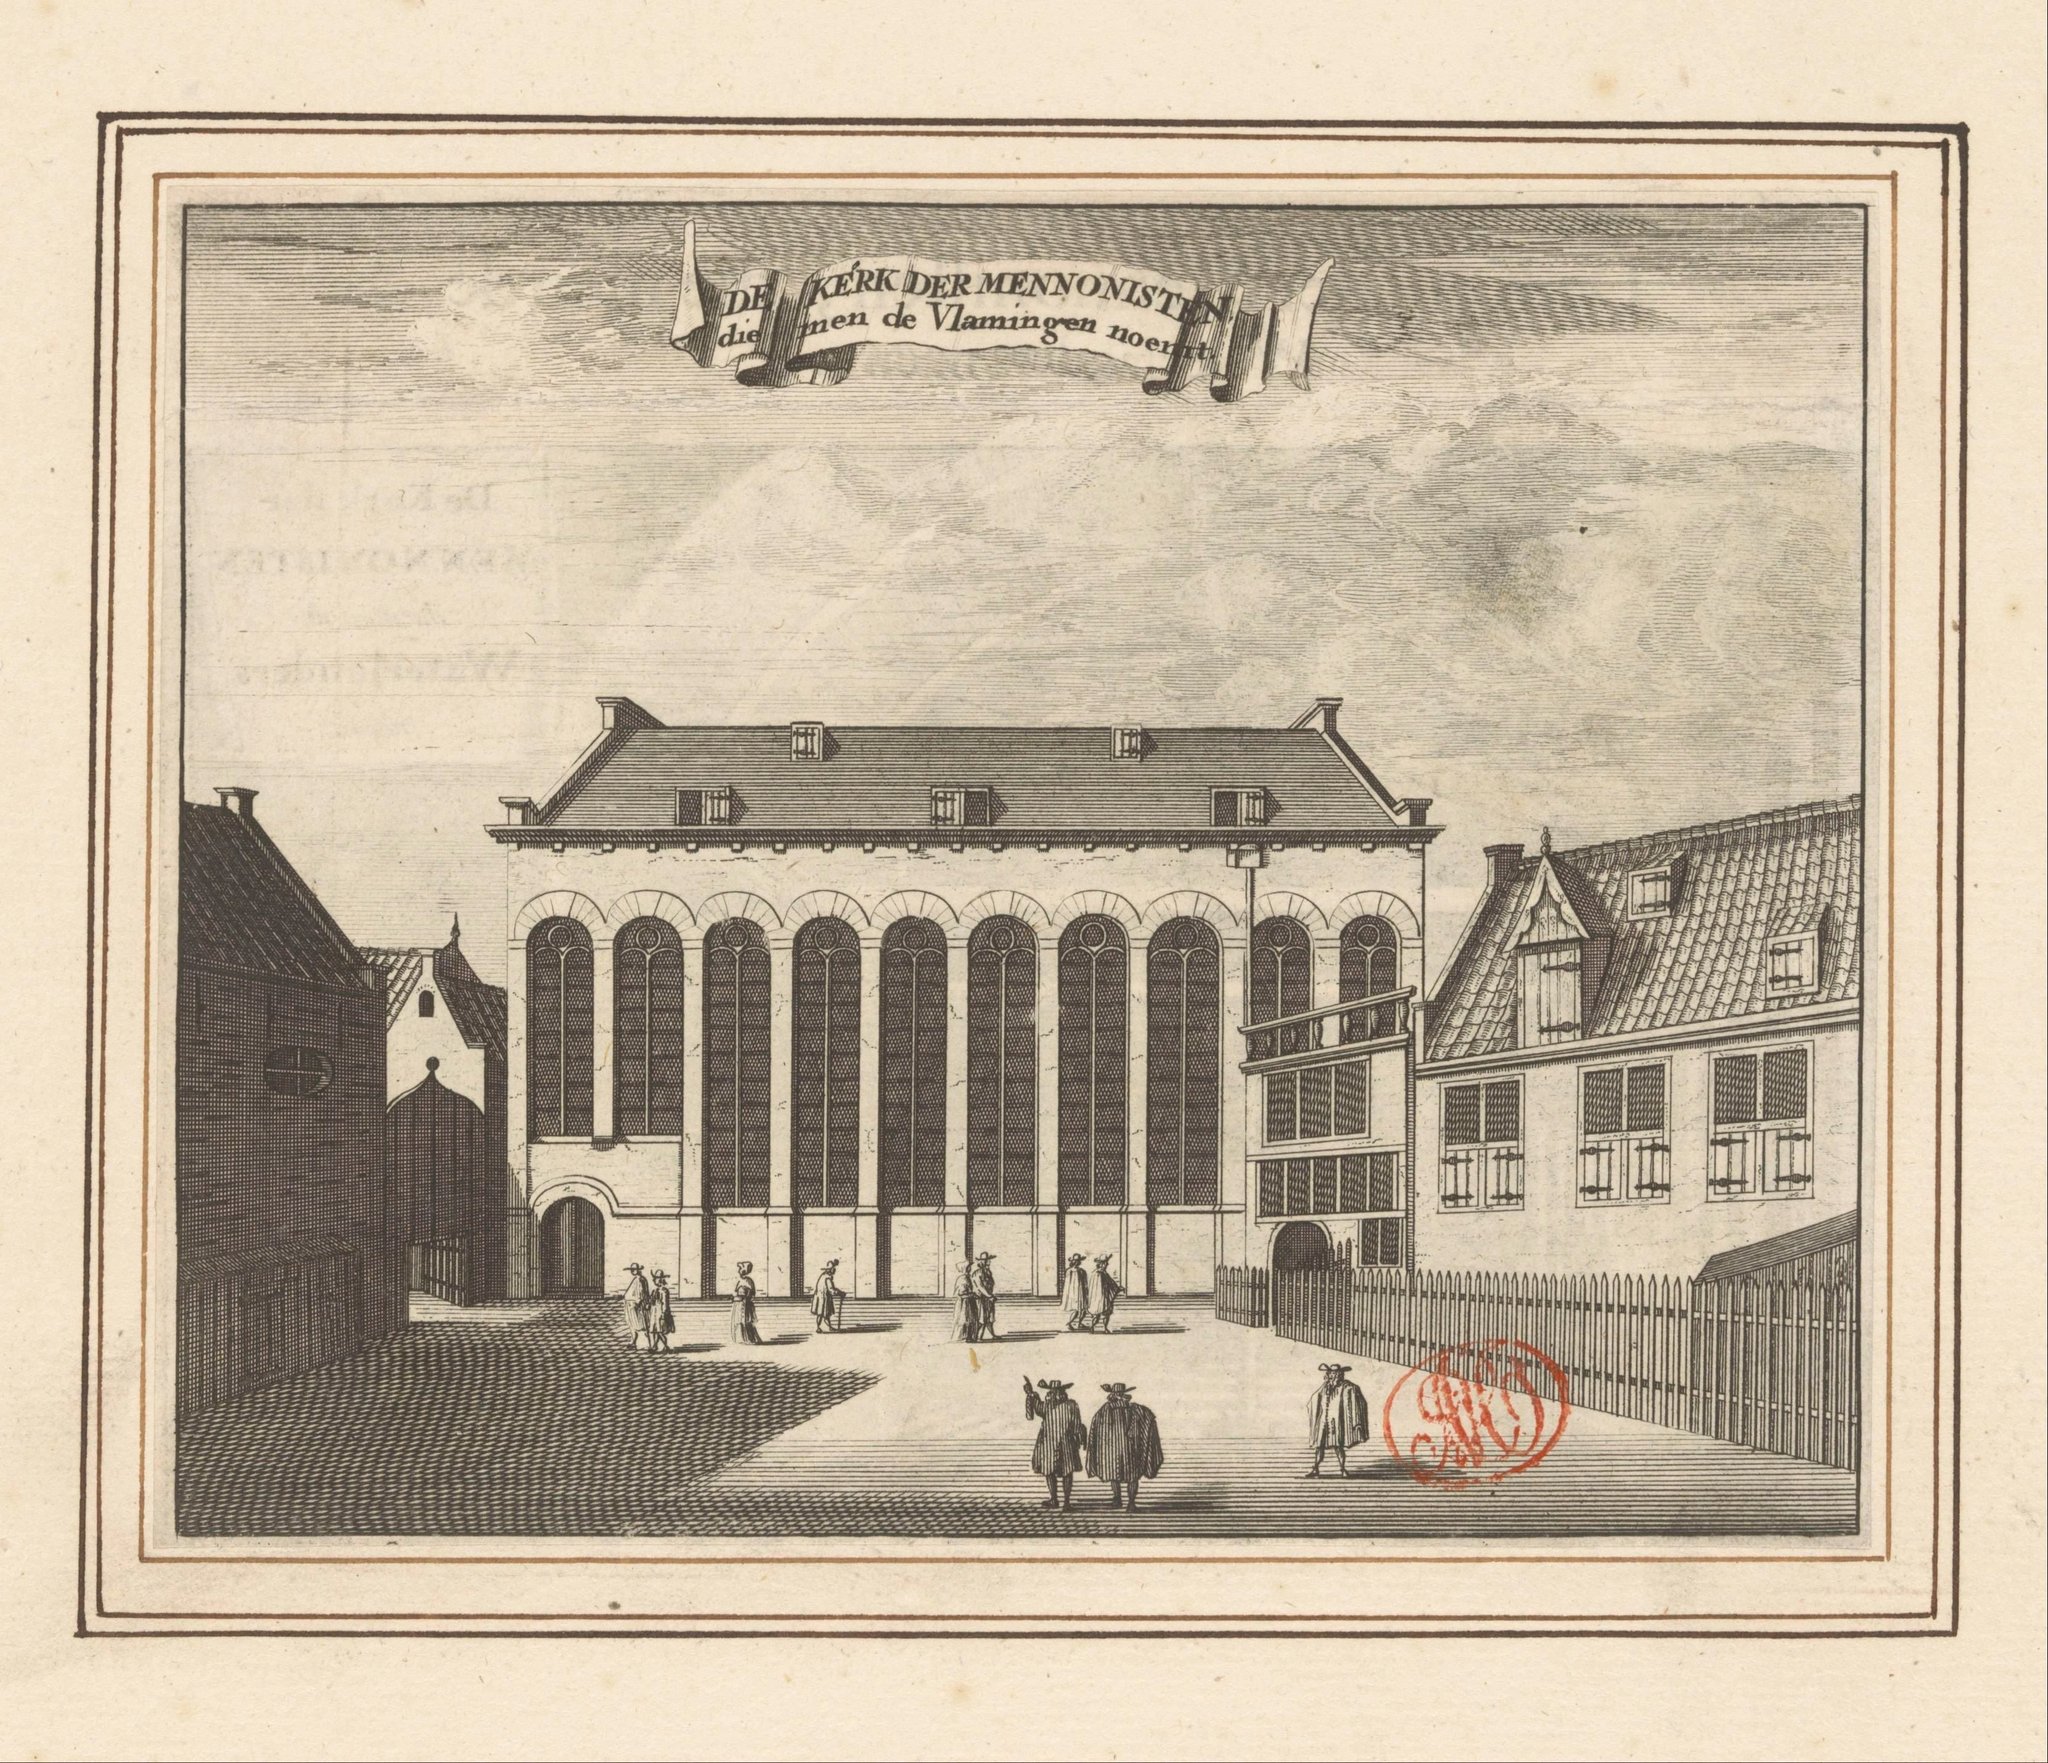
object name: print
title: Gezicht op de Doopsgezinde Kerk Bij 't Lam te Amsterdam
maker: Anonymous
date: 1693-1694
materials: paper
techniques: engraving, etching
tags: protestant churches and denominations (mennonites), church (exterior)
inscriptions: collector's mark: Lugt 2233, collector's mark: Lugt 195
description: Prent gebruikt in: Commelin, Caspar. Beschryvinge van Amsterdam, desselfs eerste oorspronk uyt den Huyse (…). 2 delen. Amsterdam: Abraham Wolfgang, Gillis Janssonius van Waesberge, Johannes Janssonius van Waesberge II, weduwe Dirk Boom I, Hendrick Boom en Rembertus Goethals, 1693. Of in: Commelin, Caspar. Beschryvinge van Amsterdam, zynde een naukeurige verhandelinge van desselfs eerste oorspronk uyt (…). 2 delen. Amsterdam: weduwe Aart Dircksz Oossaan, 1694. Op verso tekst in boekdruk en een andere prent (zelfde als RP-P-AO-24-14-2). Latere staat ook gebruikt in: Commelin, Caspar. Beschryvinge van Amsterdam, zynde een naukeurige verhandelinge van desselfs eerste oorspronk uyt (…). 2 delen. 2e druk. Amsterdam: Andries van Damme, Johannes Ratelband, weduwe A. van Aaltwyk en Hermanus Uytwerf, 1726.